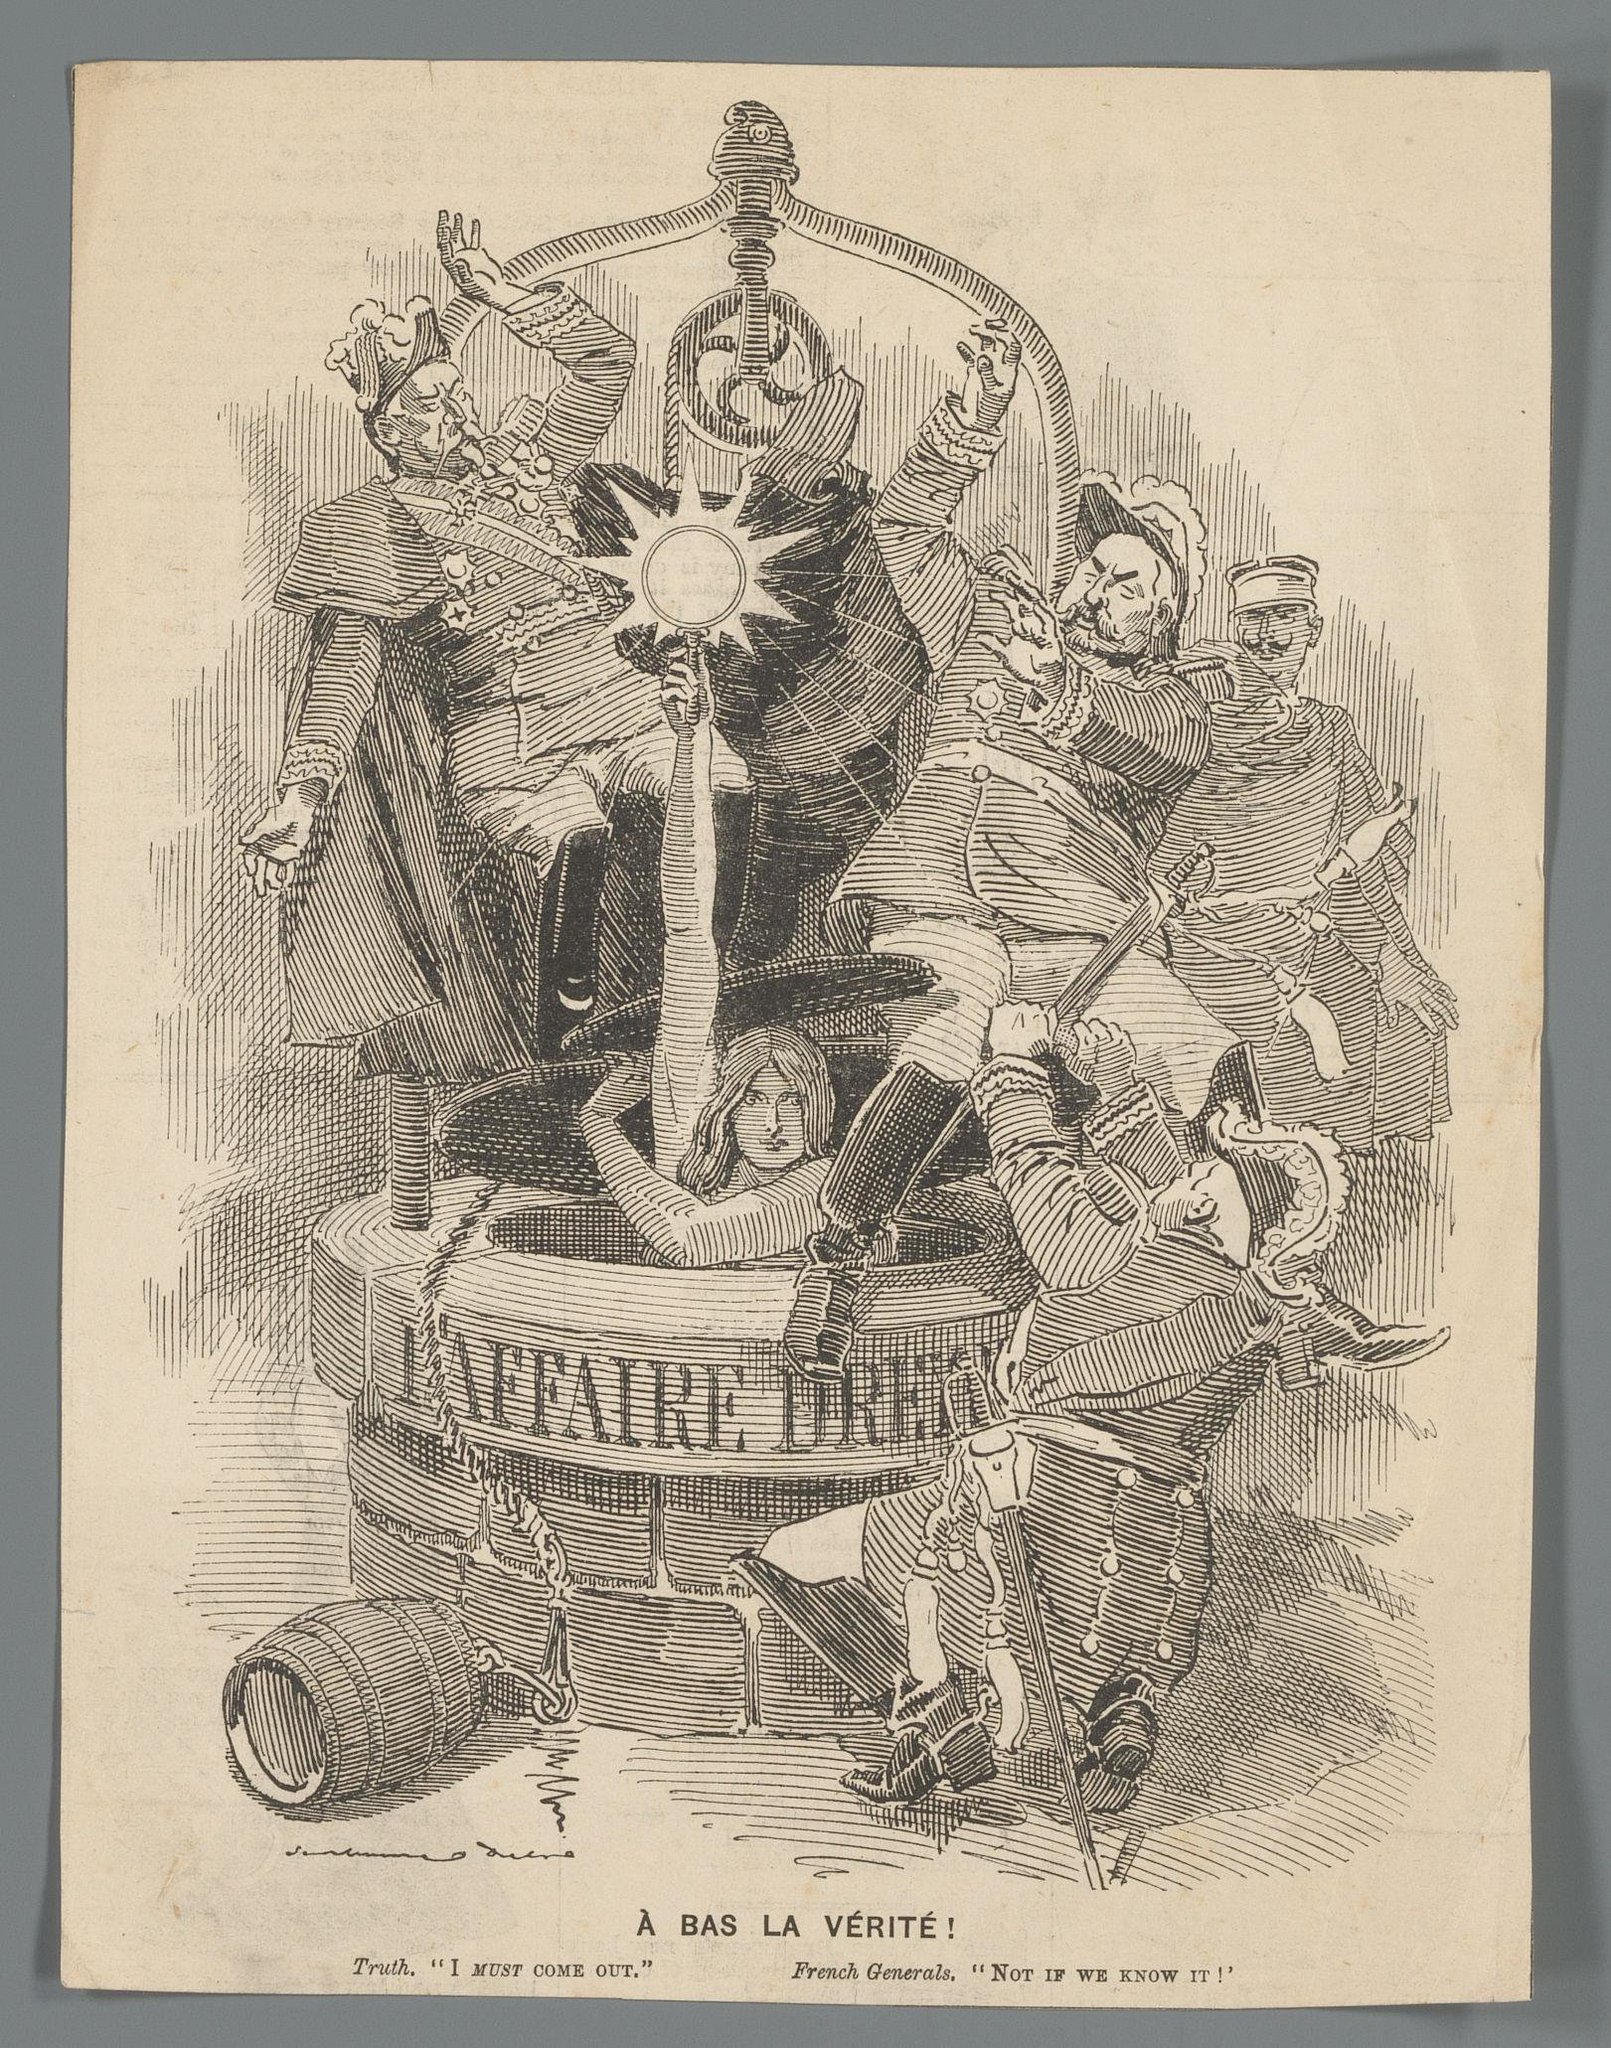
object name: cartoon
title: A bas la vérité?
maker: edward linley sambourne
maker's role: draughtsman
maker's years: 1844-1910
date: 1899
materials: paper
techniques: line block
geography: england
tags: paris, well, truth; 'verità' (ripa), political caricatures and satires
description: Spotprent over de Dreyfusaffaire. Franse generaals proberen te voorkomen dat de Waarheid uit een waterput komt, dat de waarheid bekend wordt. Spotprent uit het Engelse satirische tijdschrift Punch, 1899.